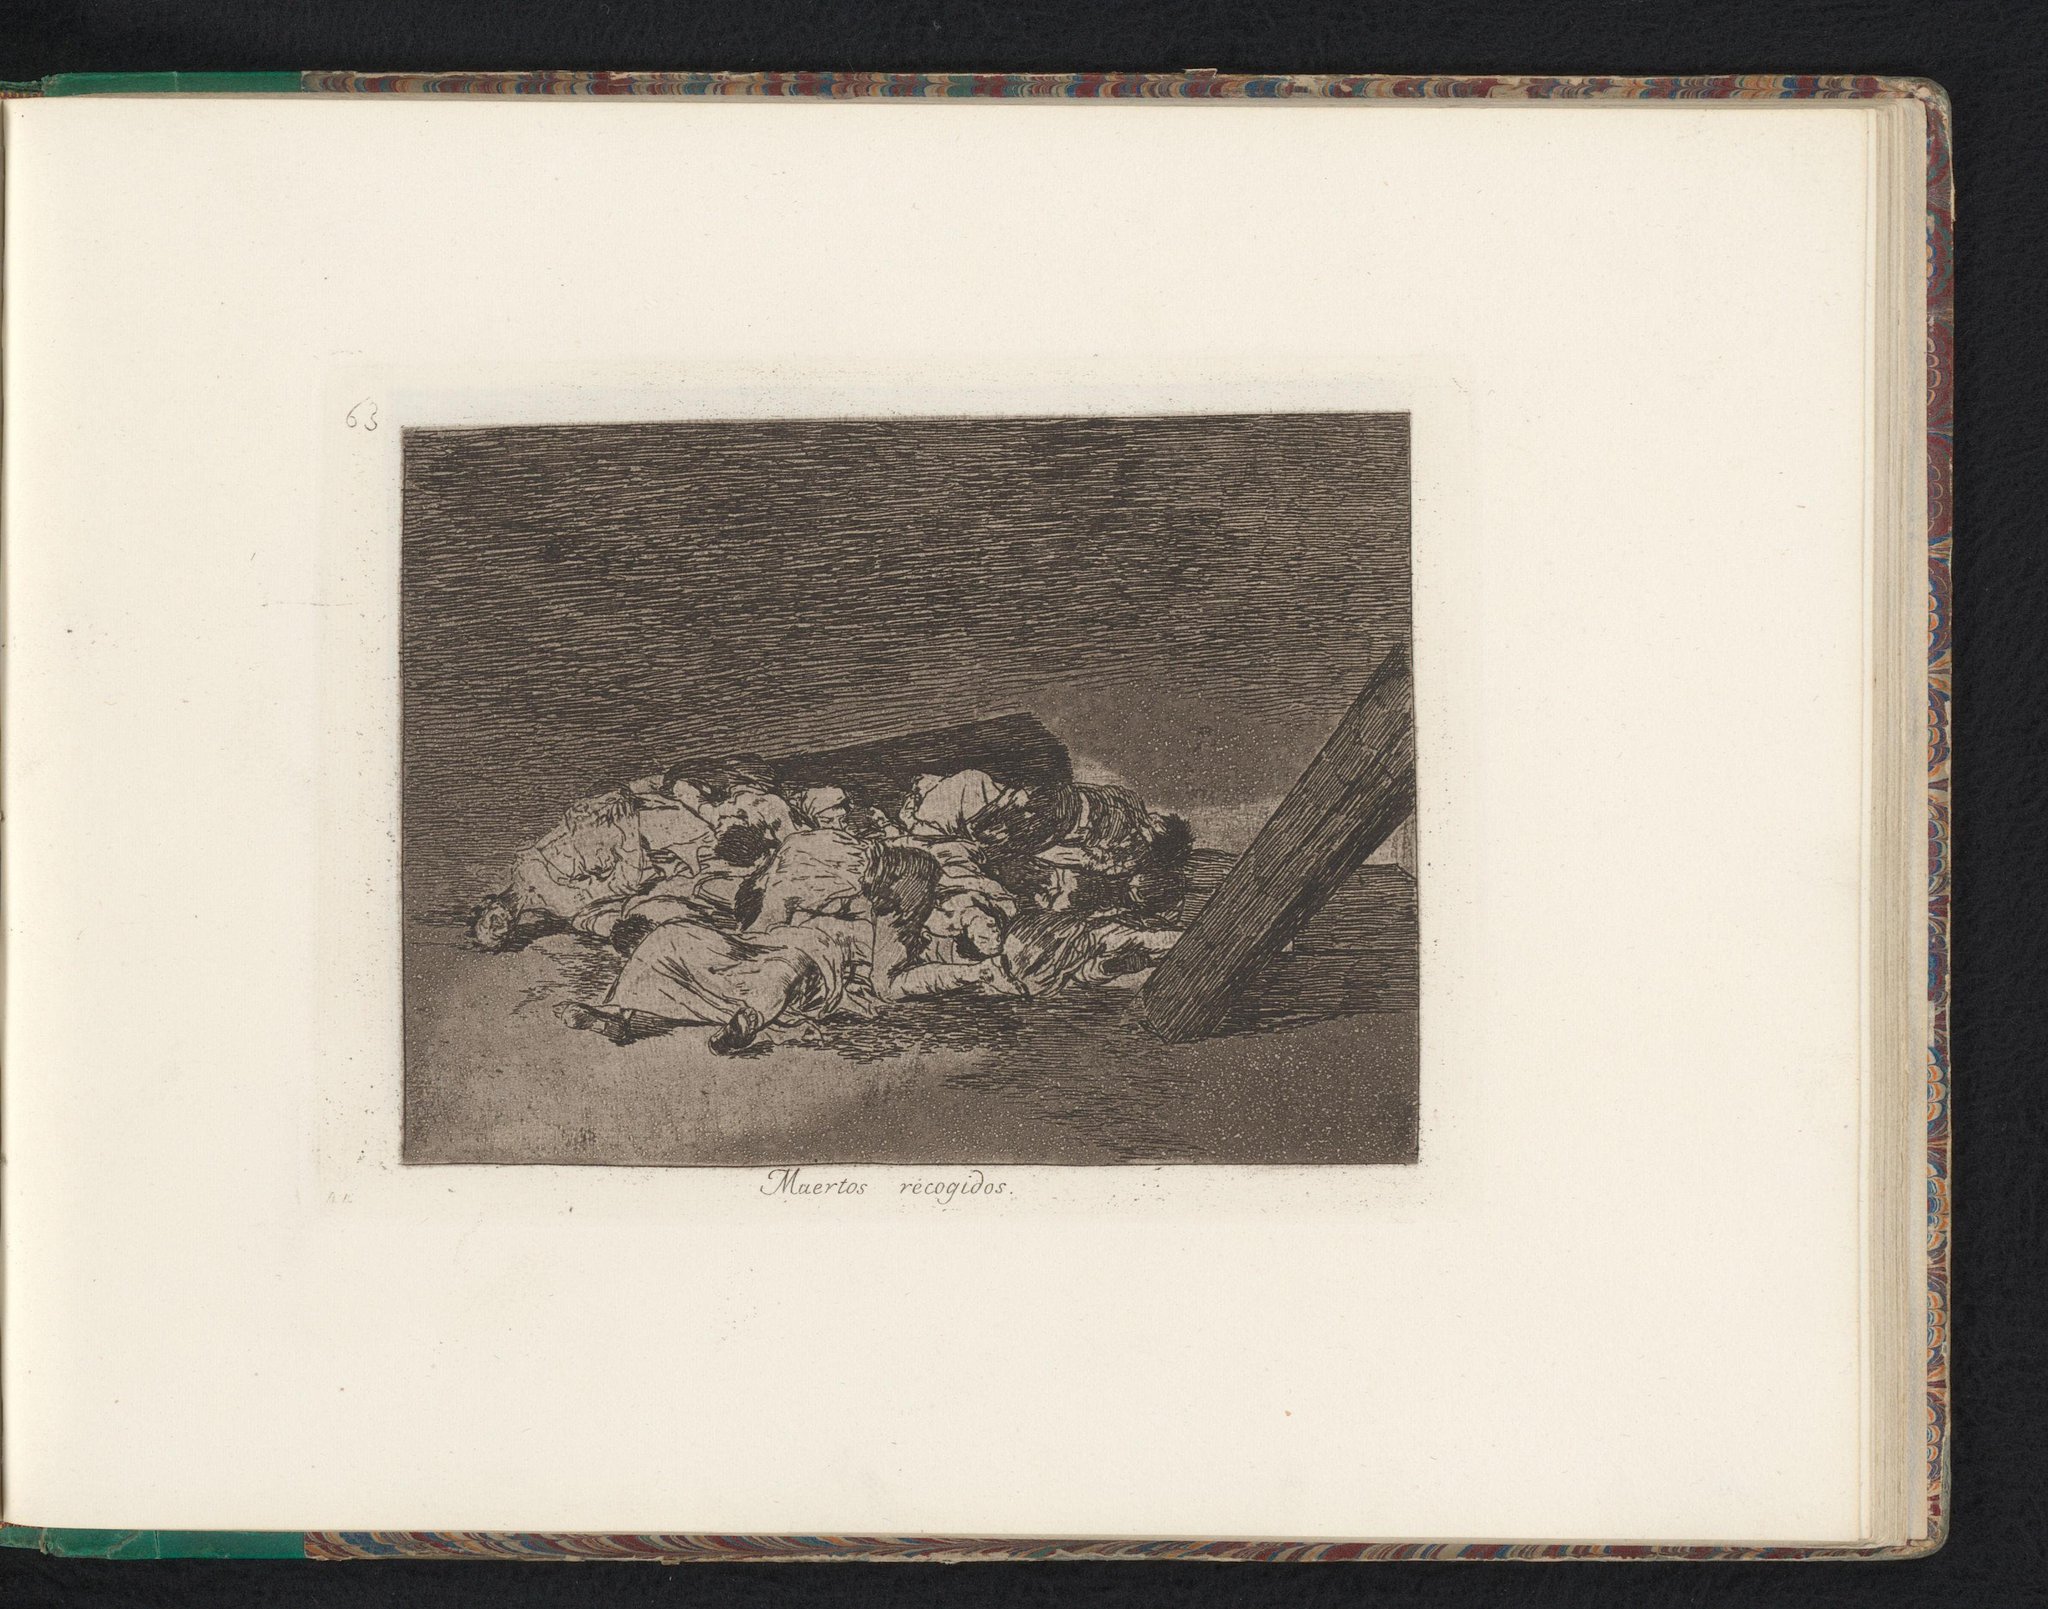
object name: album leaf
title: Los desastres de la guerra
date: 1810-1820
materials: paper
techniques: aquatint, etching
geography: madrid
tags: mass-grave, horrors of war, spain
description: Deze prent maakt deel uit van een album.